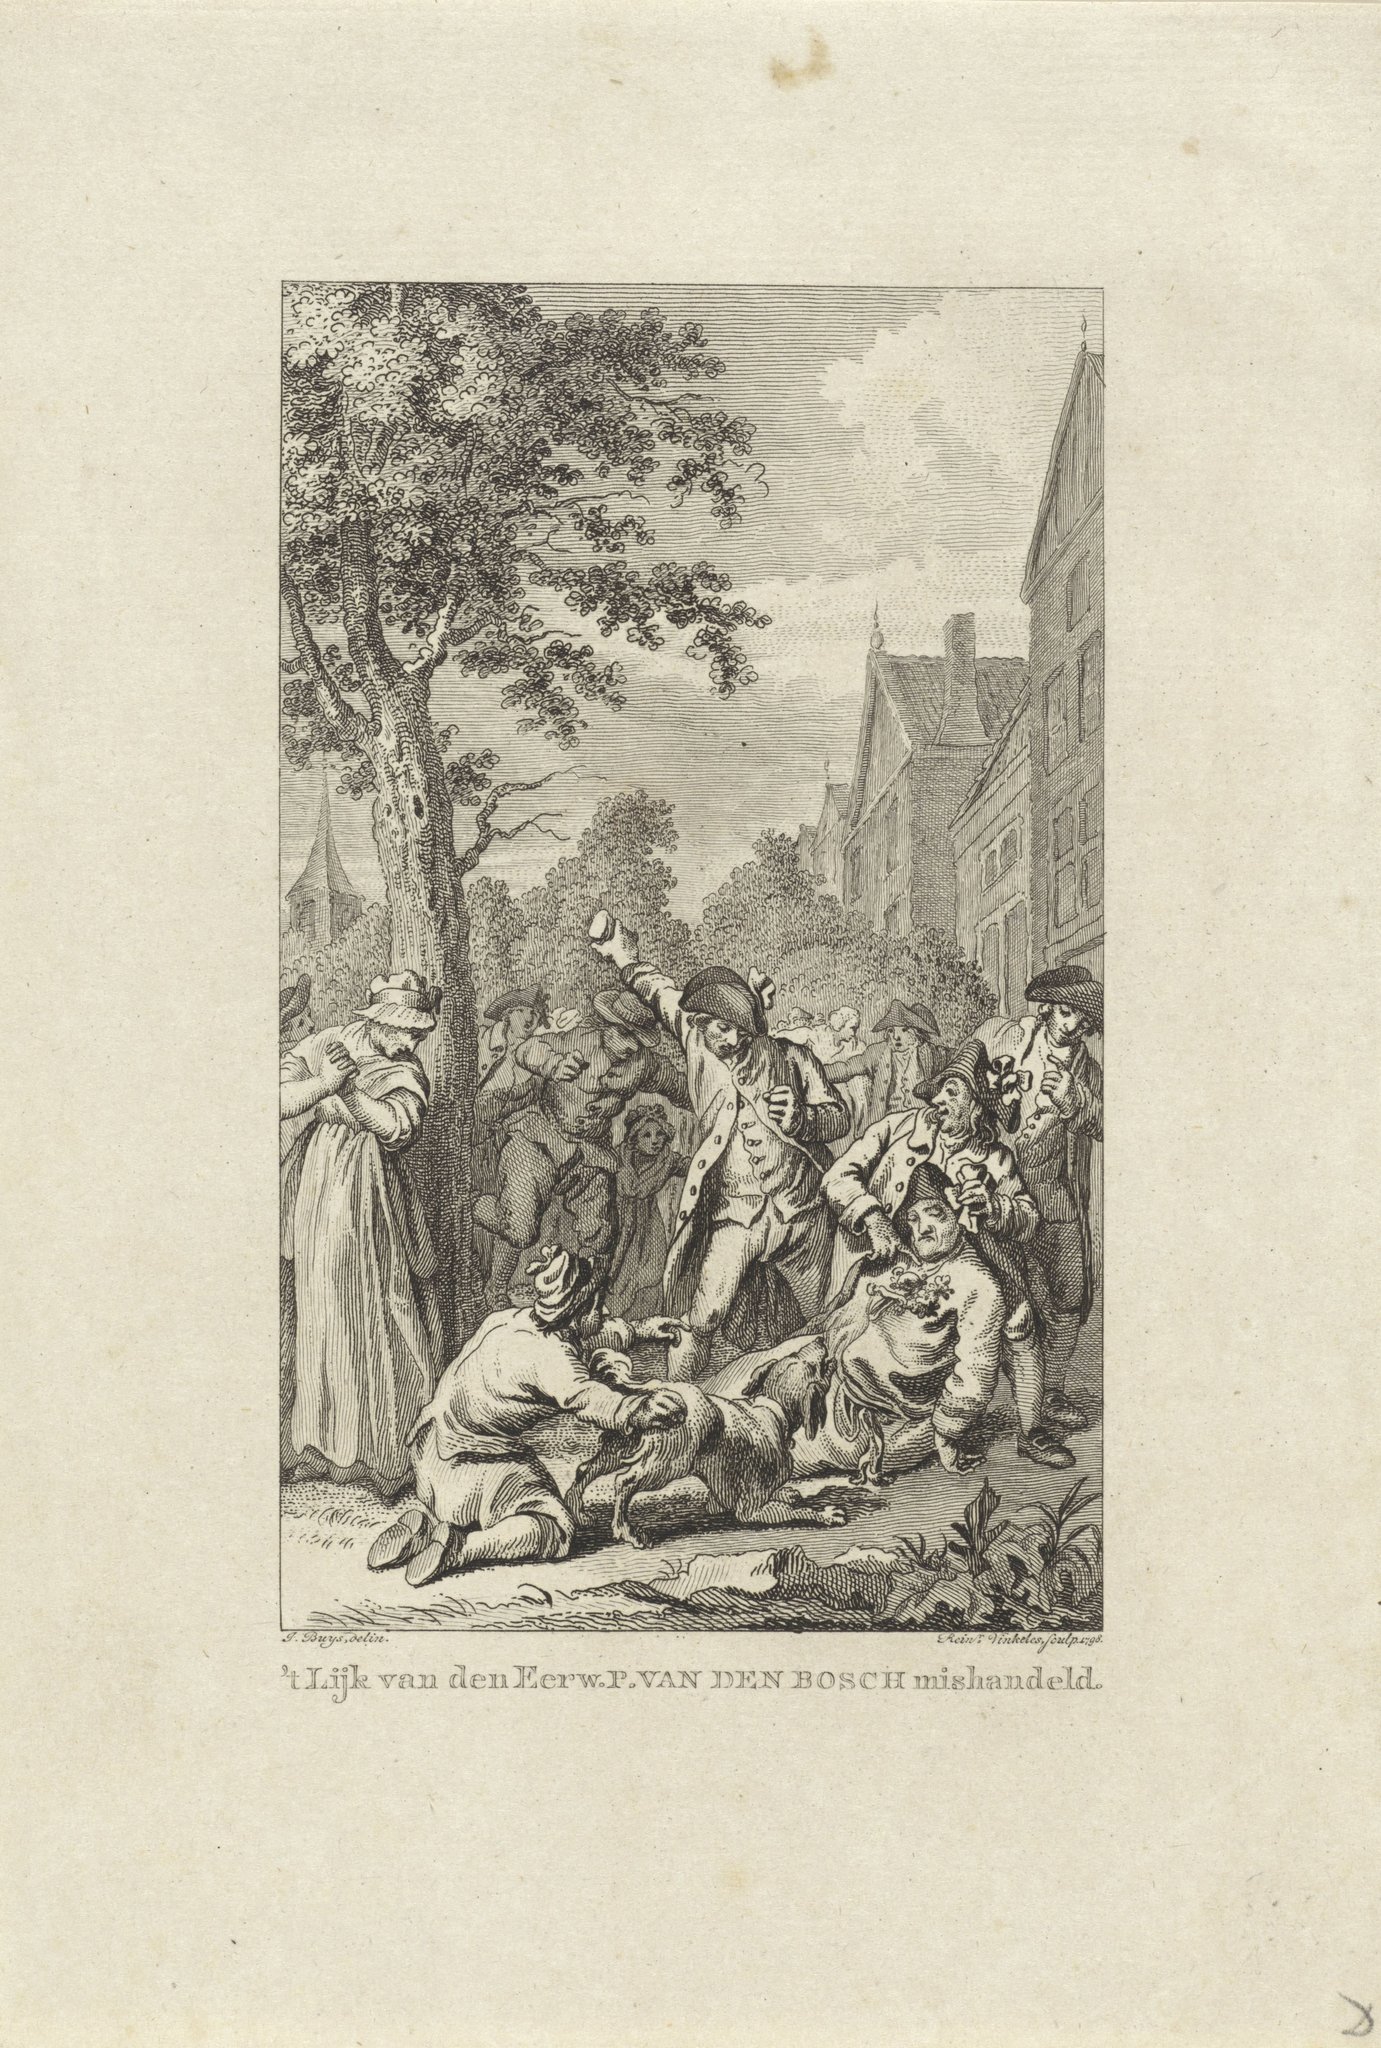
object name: print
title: Mishandeling van het lijk van predikant P. van den Bosch te Zoetermeer, 1787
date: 1798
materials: paper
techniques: engraving, etching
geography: amsterdam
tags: violation of the corpse, patriots (1780-1795)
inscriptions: date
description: Gebruikt als illustratie in: P.A. Loosjes. Vaderlandsche historie, vervattende de geschiedenissen, der Vereenigde Nederlanden (...). Ten onmiddelyken vervolge van Wagenaar's Vaderlandsche historie. Amsterdam: Johannes Allart, dl. 20.